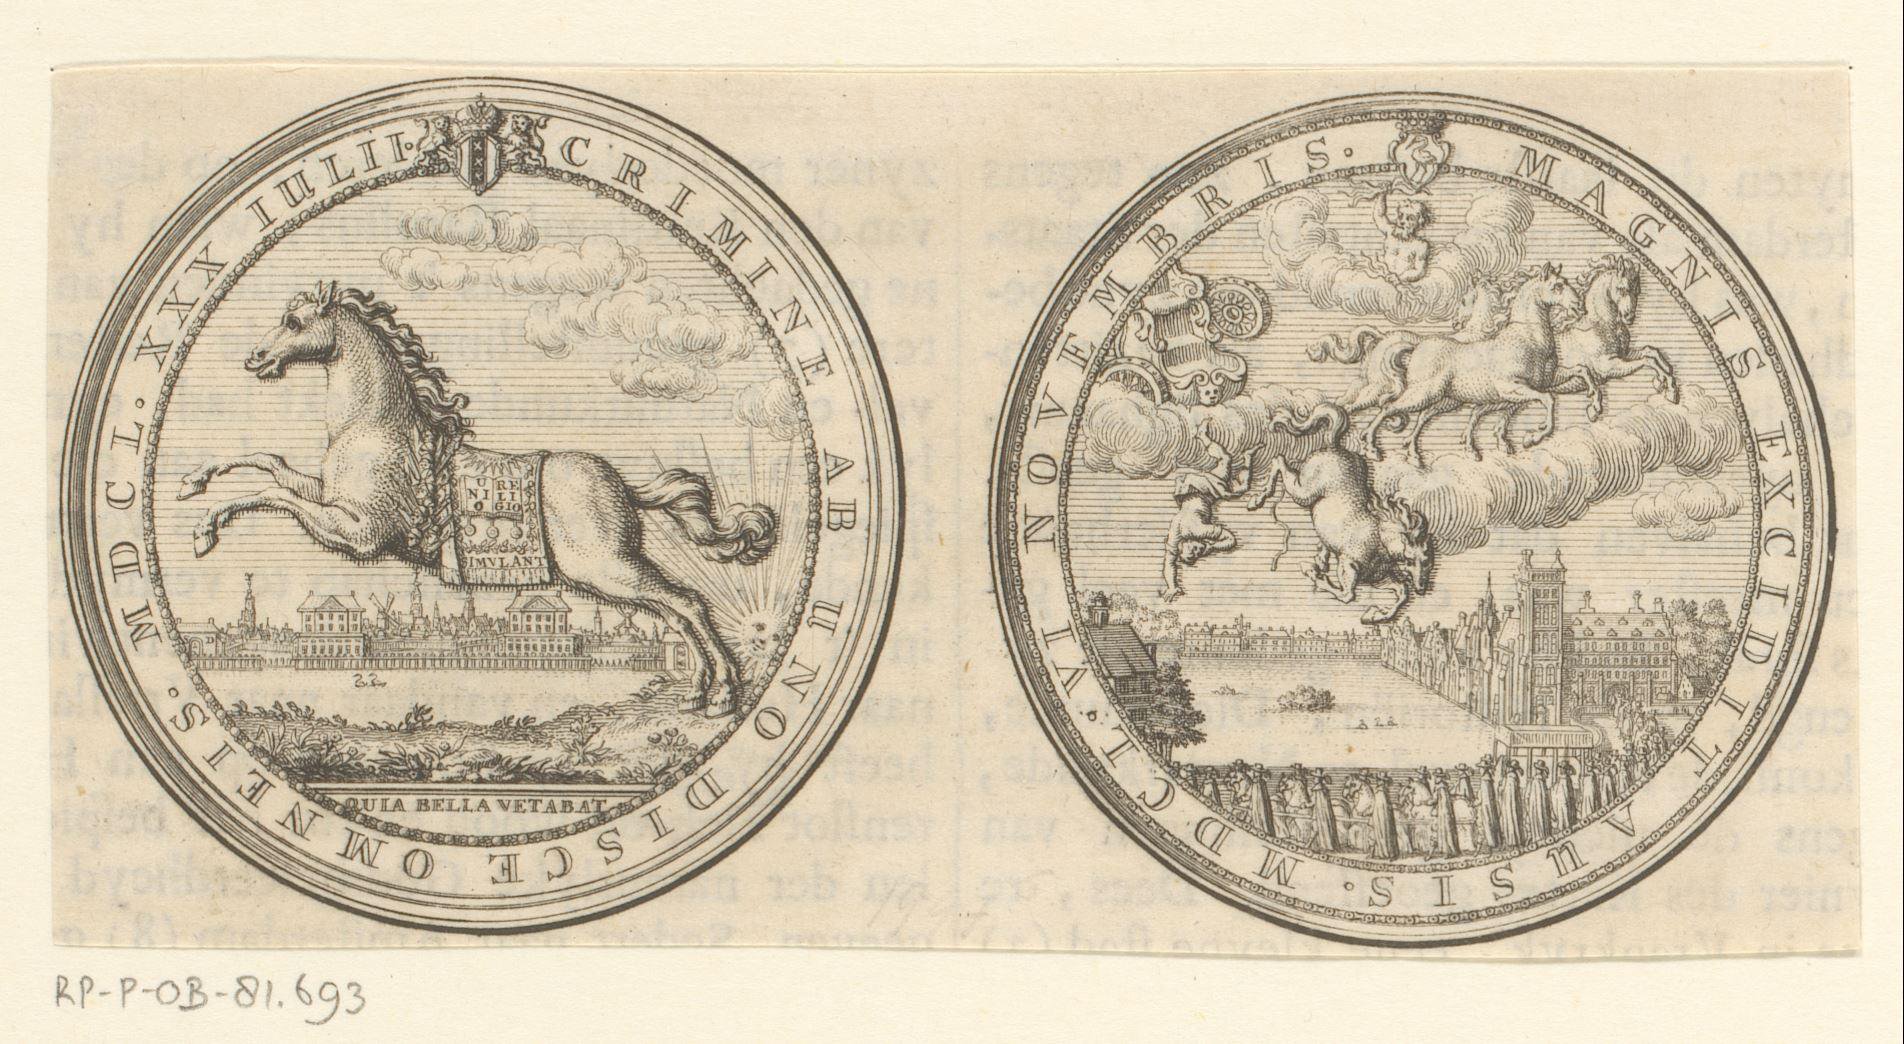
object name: print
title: Penning op het overlijden van Willem II, 1650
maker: Anonymous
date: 1724-1726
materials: paper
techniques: etching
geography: northern netherlands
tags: william ii (prince of orange), medal (considered as a piece of sculpture, regardless of its specific function), amsterdam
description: Een penning over de mislukte aanslag op Amsterdam door prins Willem II op 30 juli 1650 en de begrafenisstoet van de prins in Den Haag, 8 maart 1651. Voorzijde: rennend paard, met krijgslieden onder dekkleed; op achtergrond gezicht op de blokhuizen aan de Amstel. Keerzijde: de val van Phaëthon, daaronder de lijkstoet bij het Hof in Den Haag. Uitgeknipte illustratie bedrukt met tekst op achterzijde.